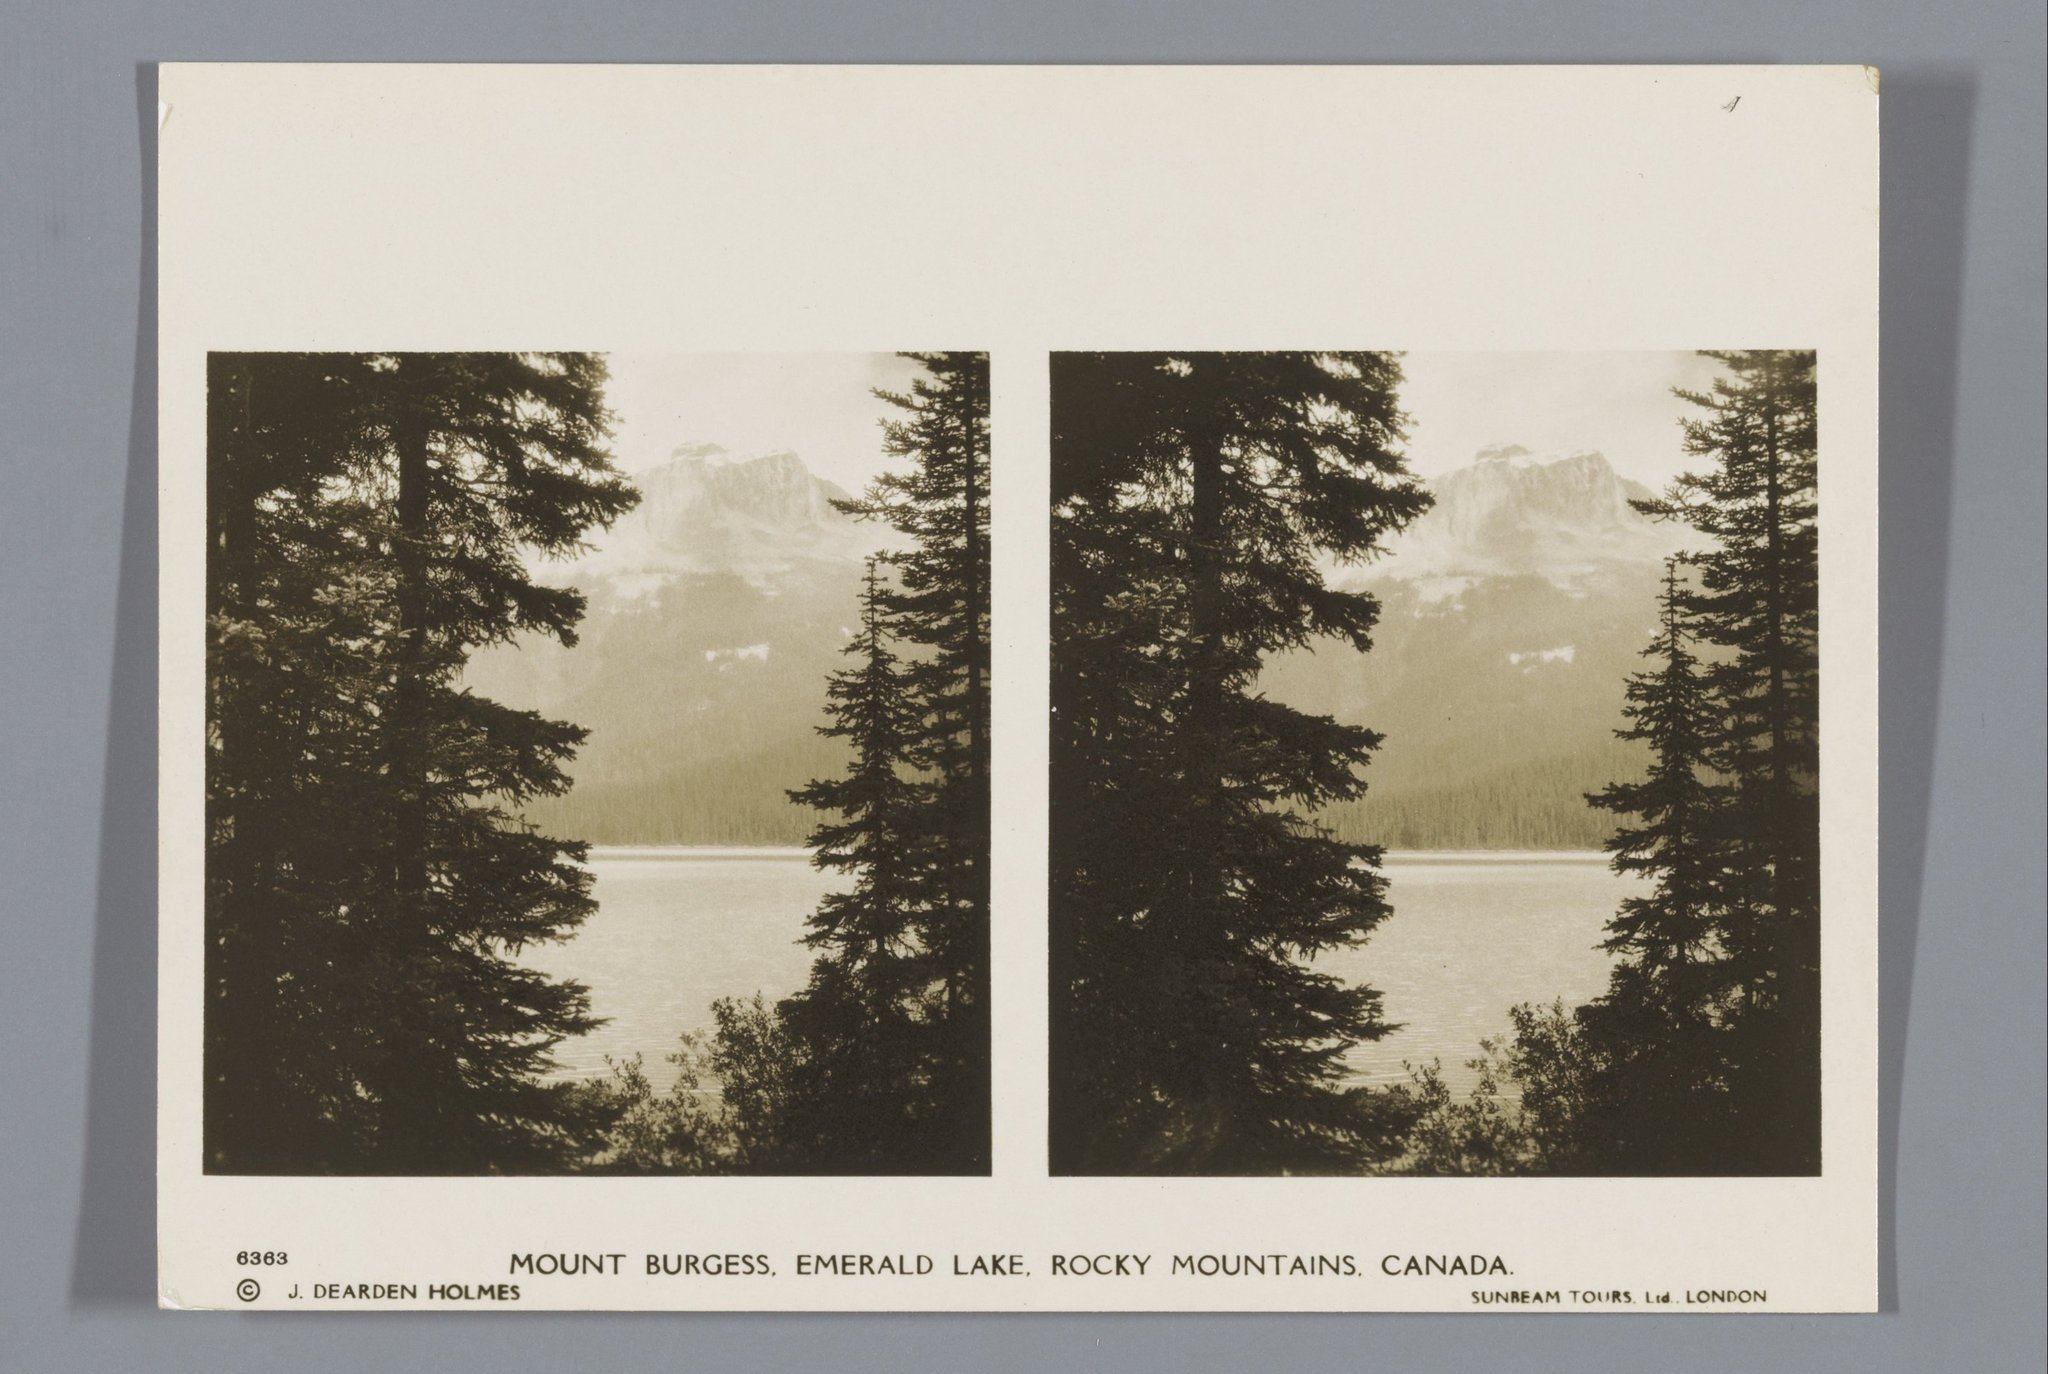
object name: stereograph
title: Gezicht op Emerald Lake en Mount Burgess, Canada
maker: james dearden holmes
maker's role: fotograaf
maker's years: 1873-1937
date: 1924-1926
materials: paper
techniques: gelatin silver print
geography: london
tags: trees: spruce, mountain-range, snow peaks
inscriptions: number: ‘6363’